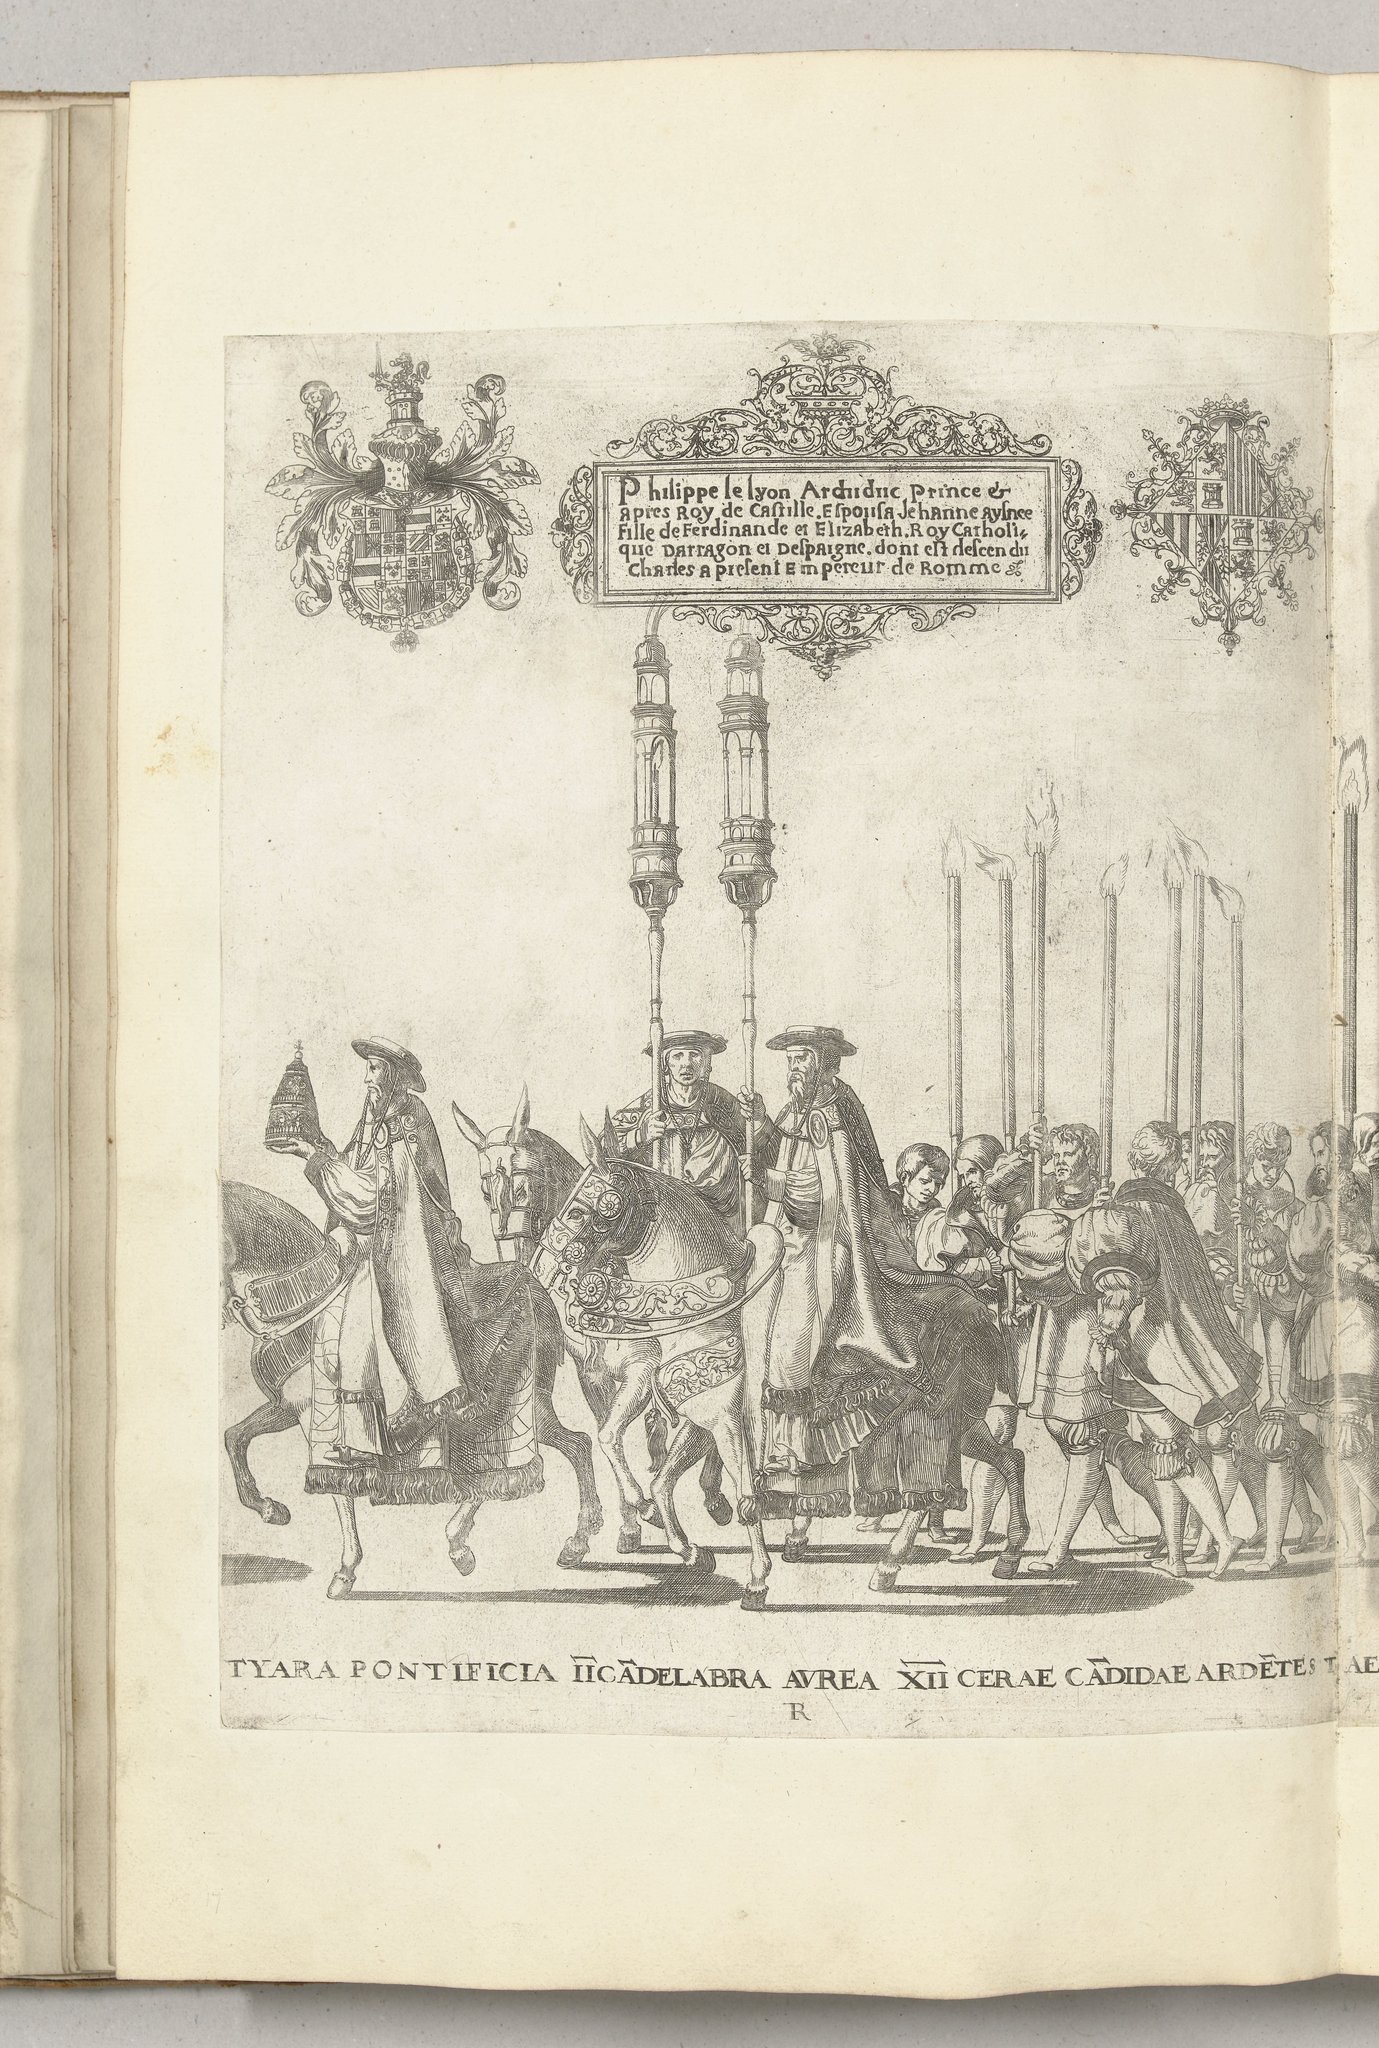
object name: print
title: Pauselijke tiara en kandelaren, plaat R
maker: nicolaas hogenberg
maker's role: draughtsman, painter, print maker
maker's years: 1500-1539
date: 1530-1536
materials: paper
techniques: etching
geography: mechelen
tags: ghent, charles v (holy roman emperor and king of spain), rome, festivities (+ parade, pageant, cavalcade ~ festive activities)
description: Prent in het album waarin zijn ingeplakt de 40 platen die achterelkaar samen het fries vormen van de optocht van Karel V met de paus Clemens VII te Bologna na zijn kroning tot keizer, 24 februari 1530.